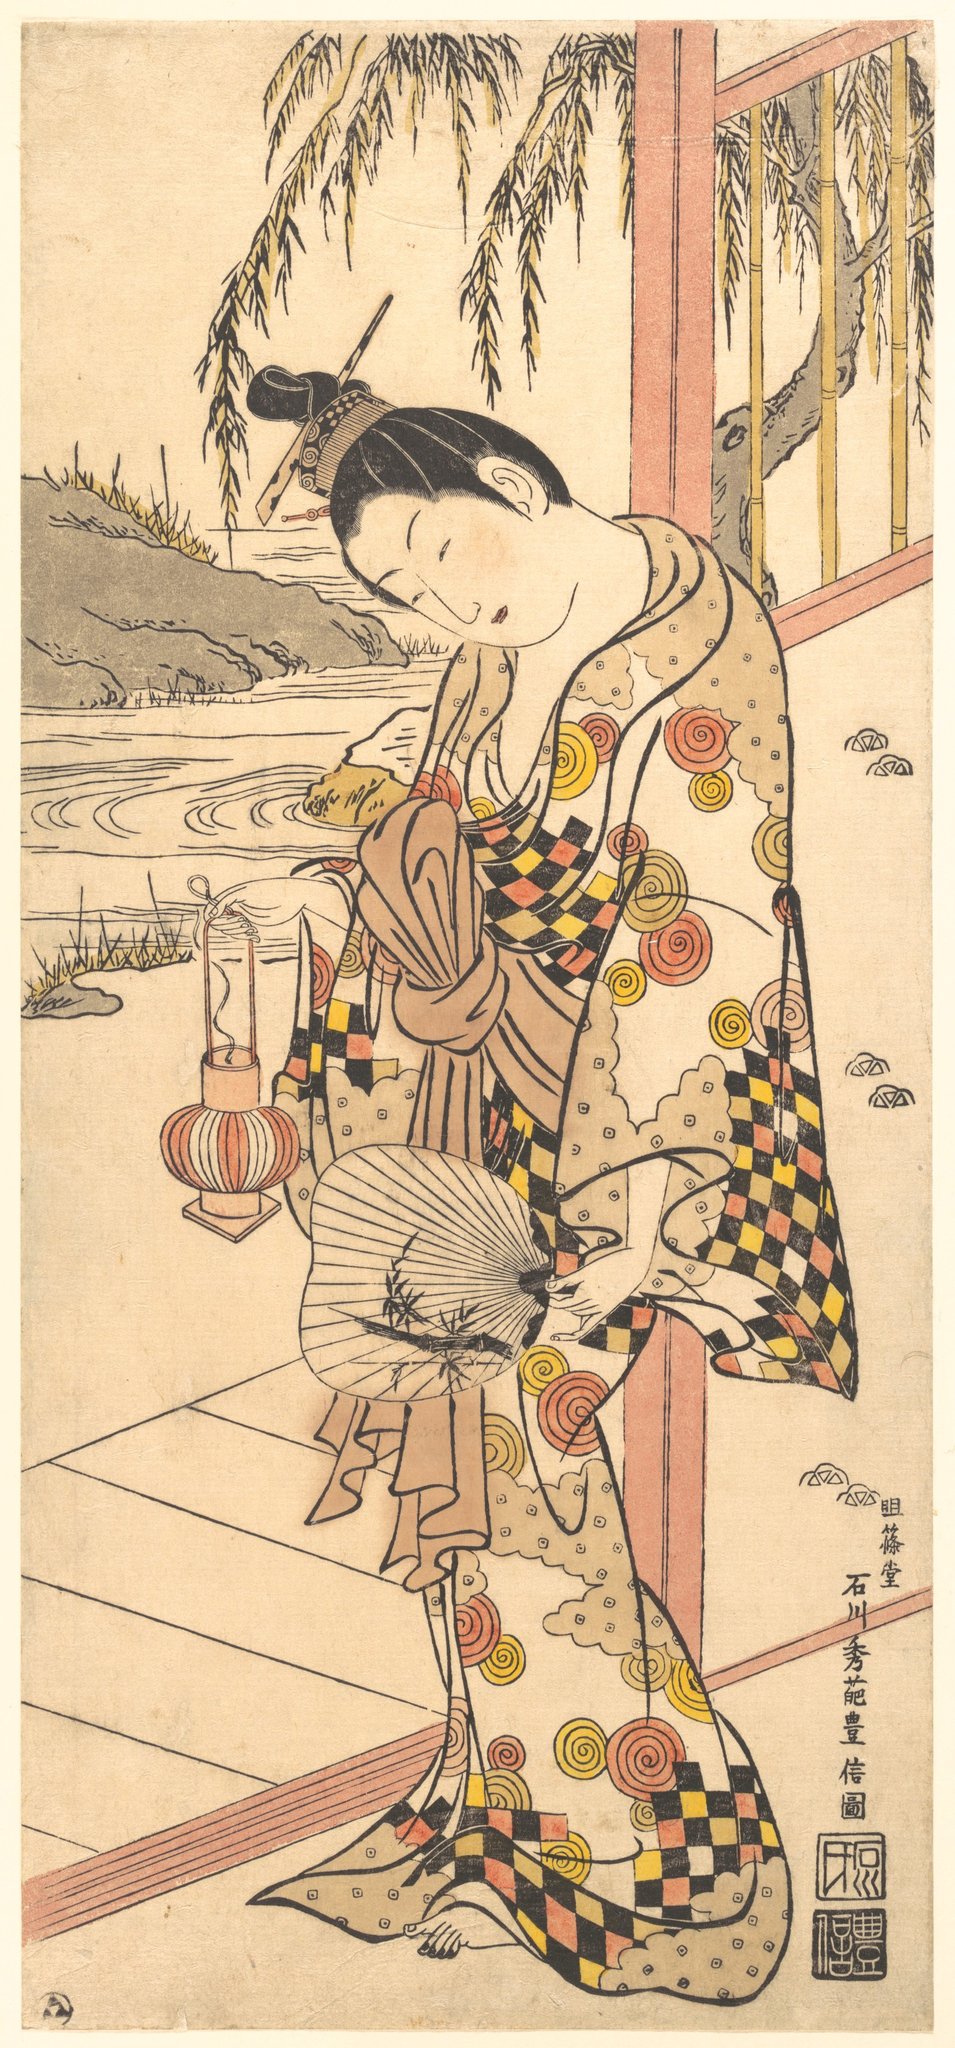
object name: print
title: Young Lady in Summer Attire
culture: japanese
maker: ishikawa toyonobu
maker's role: artist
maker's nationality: japanese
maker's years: 1711-1785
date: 1748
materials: ink, paper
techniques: hand coloring, woodblock print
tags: fans,women,lanterns